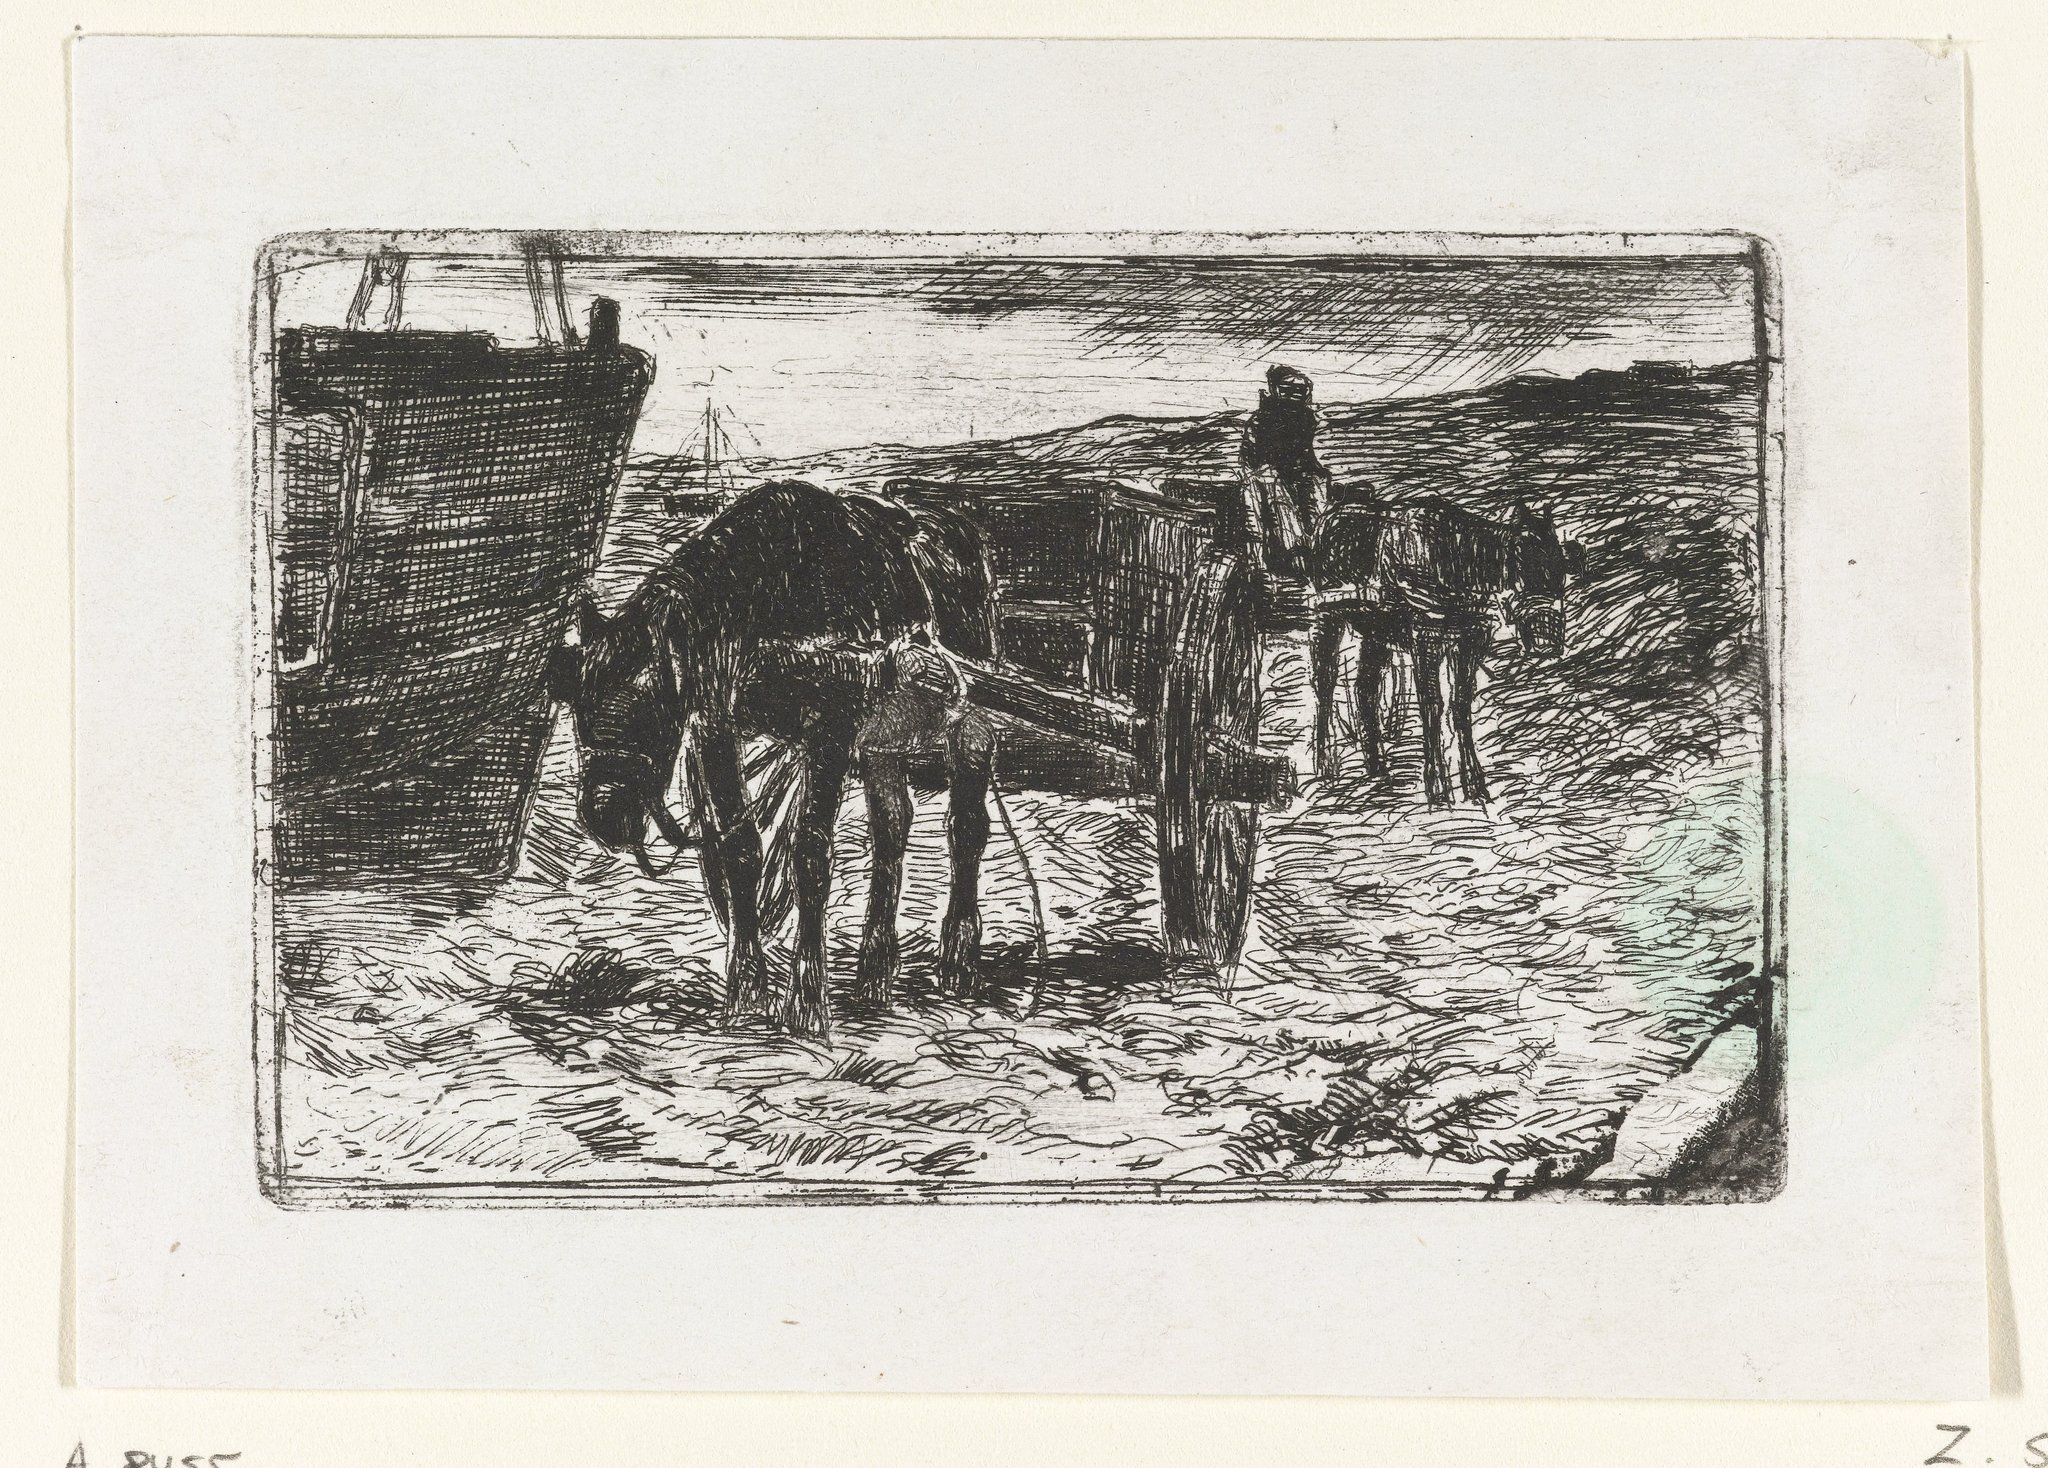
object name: print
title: Wagens op het strand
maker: anton mauve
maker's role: draughtsman, painter, print maker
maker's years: 1838-1888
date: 1848-1885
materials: paper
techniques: etching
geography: netherlands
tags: horse, two-wheeled vehicle drawn by one animal, beach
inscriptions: collector's mark: Lugt 2228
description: Paard en wagen op het strand met links het achtersteven van een schip. Op de achtergrond een paard en wagen met een man op de bok.